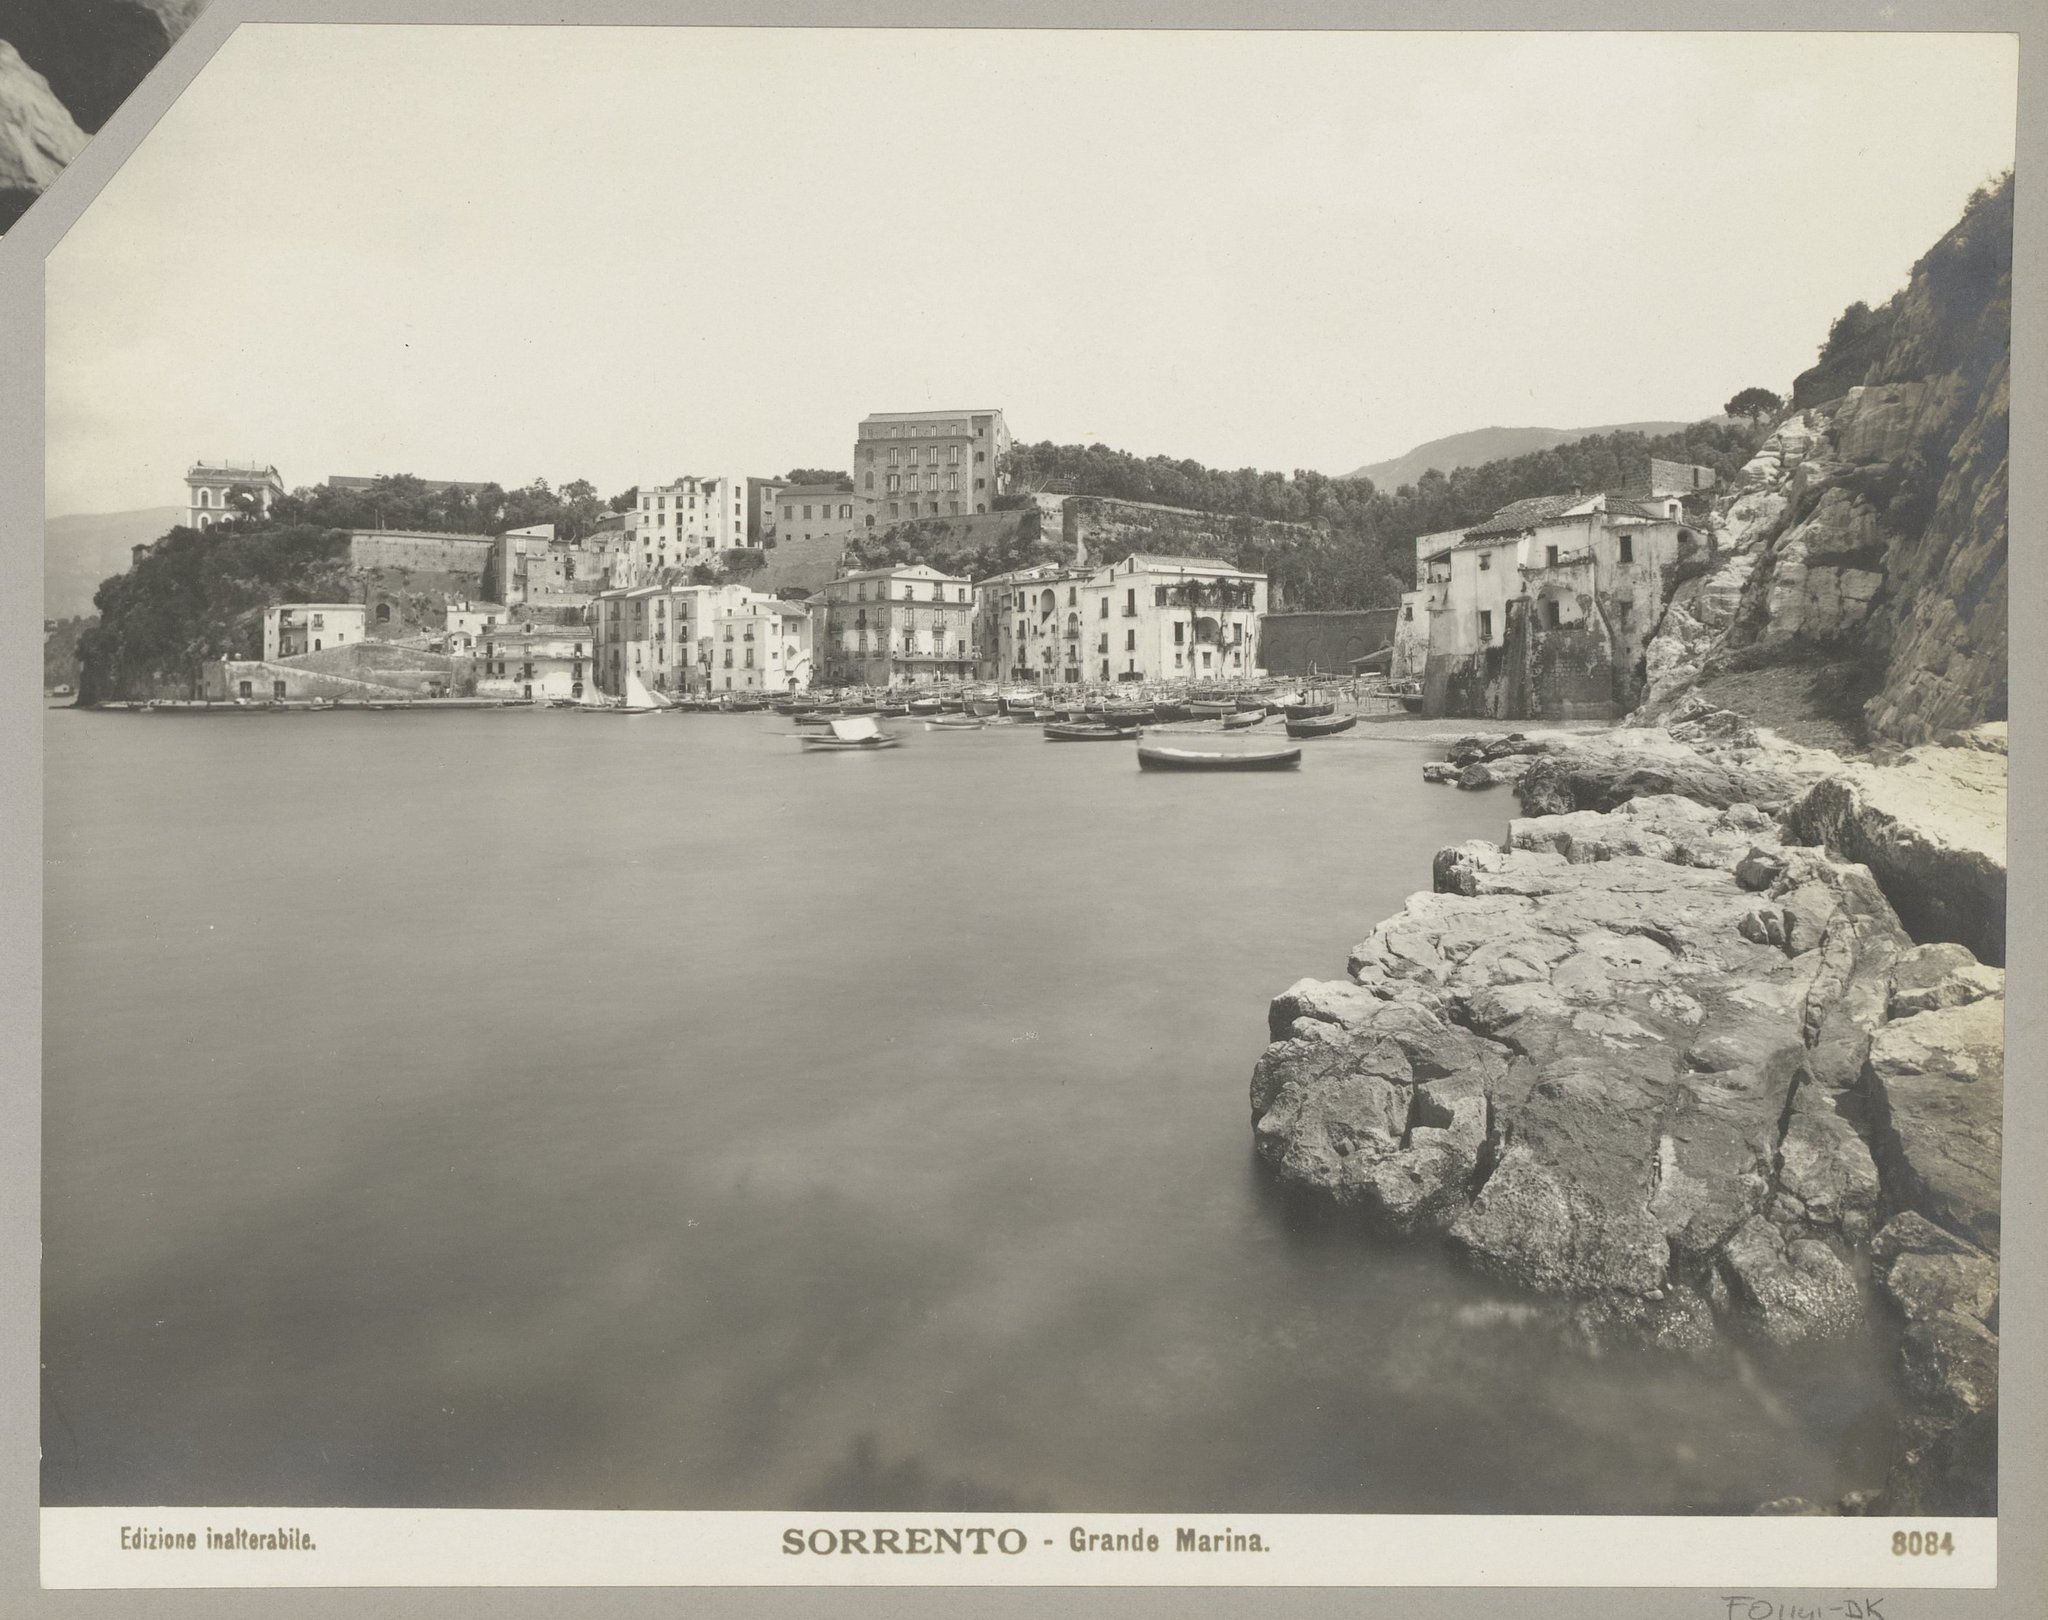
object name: photograph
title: SORRENTO - Grande Marina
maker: Anonymous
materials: photographic support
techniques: gelatin silver print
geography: sorrento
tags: harbour (+ view ~ vehicle, ship, etc.), sorrento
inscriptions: number: ‘8084’, inscription: ‘Edizione inalterabile’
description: Onderdeel van Fotoalbum van een reis door Zuid-Europa en het Midden-Oosten.